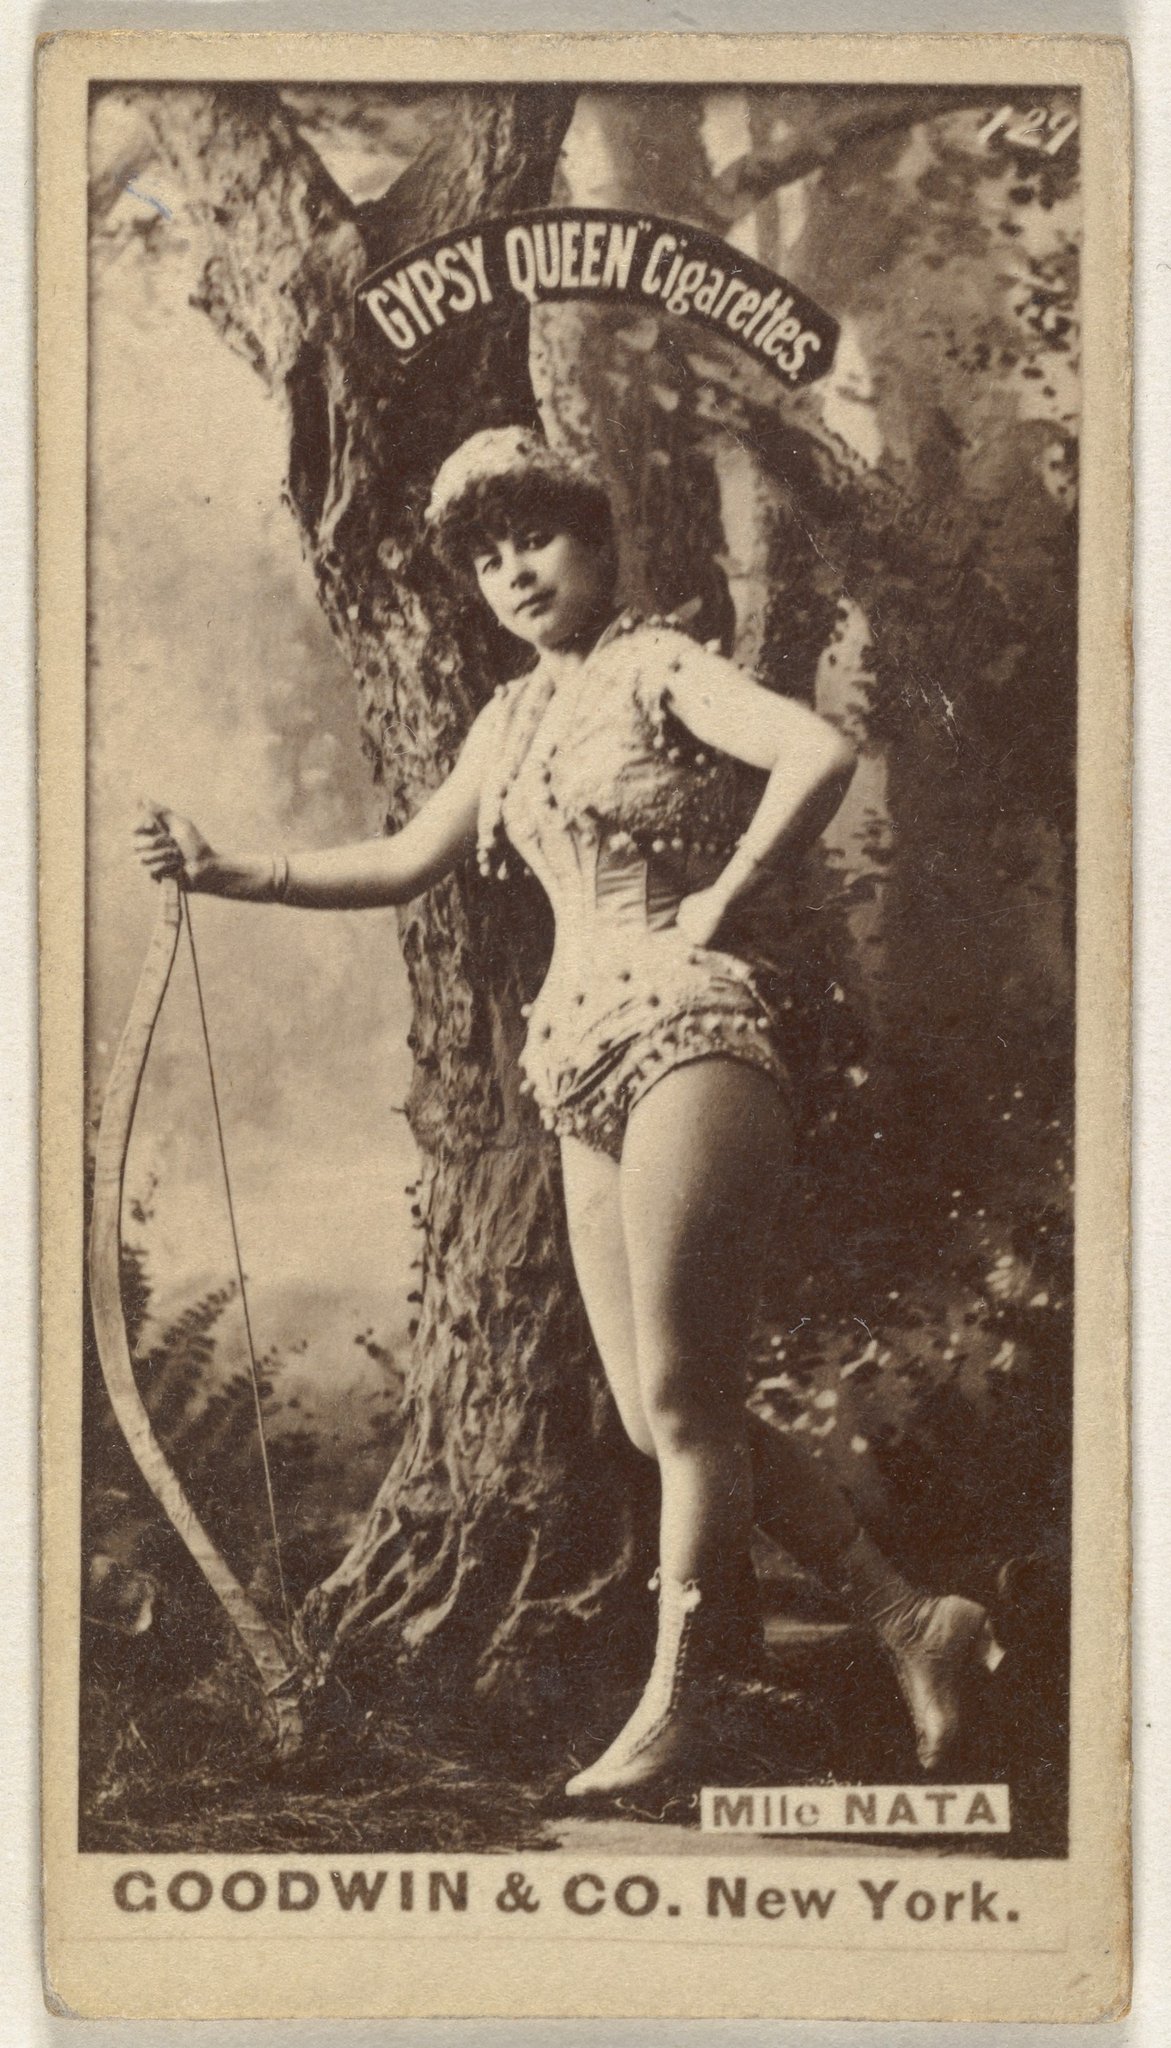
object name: photograph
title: Mlle. Nata, from the Actors and Actresses series (N171) for Gypsy Queen Cigarettes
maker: goodwin & company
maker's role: publisher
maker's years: 1850-1950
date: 1886-1890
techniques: albumen silver print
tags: portraits,women,actresses